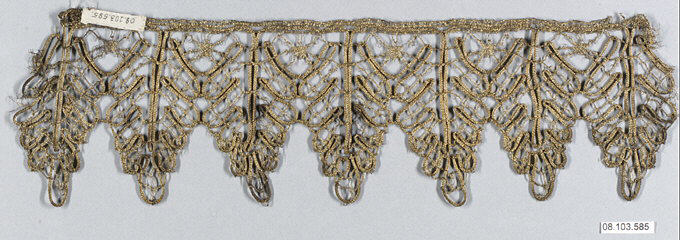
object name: piece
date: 1701-1900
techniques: lace